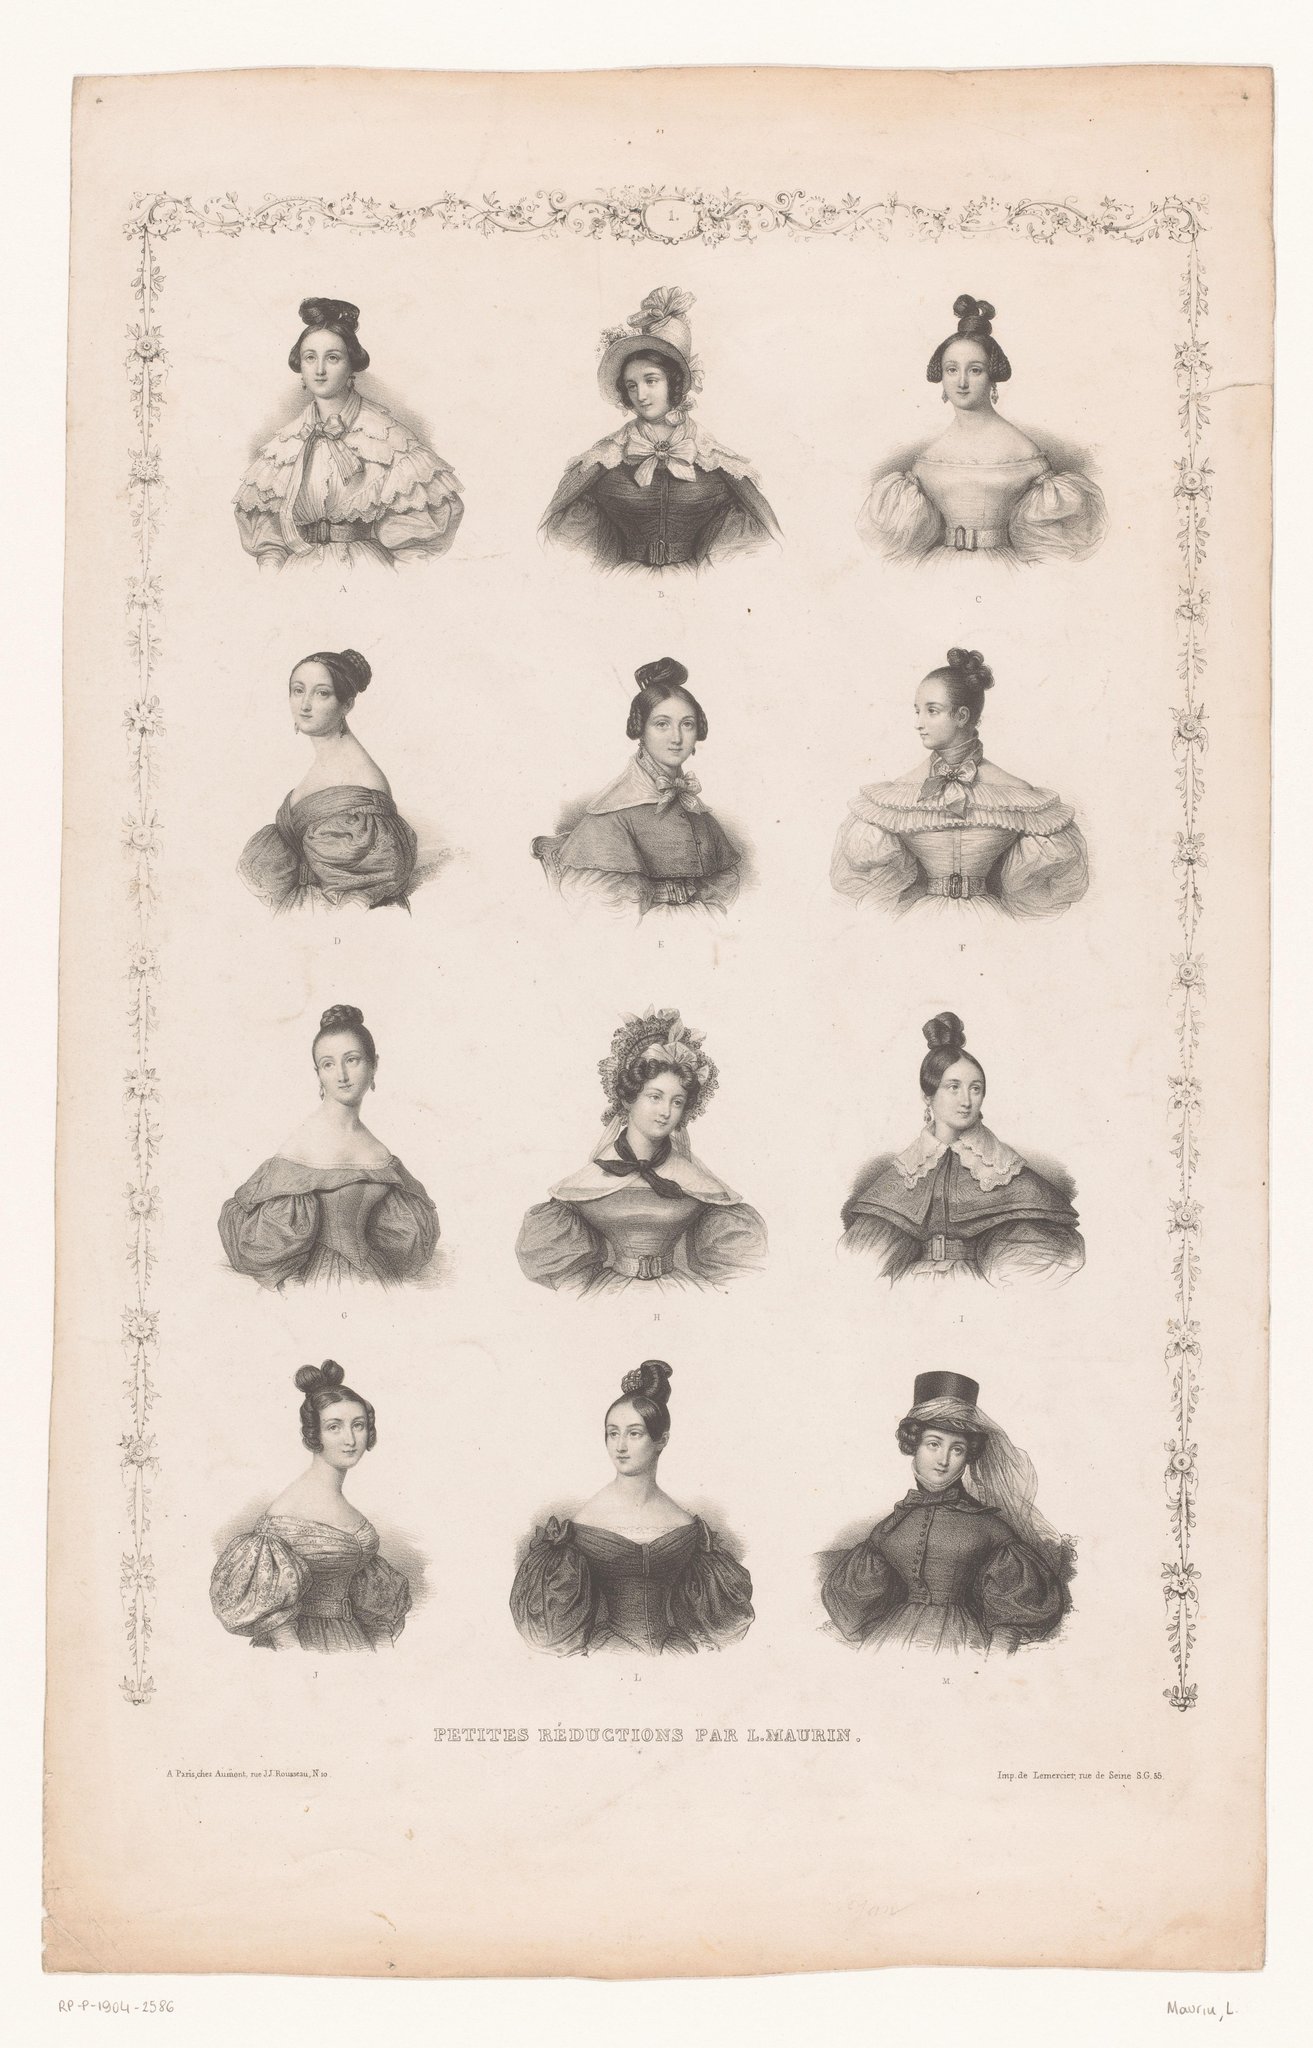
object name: print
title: Petites réductions par L. Maurin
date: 1828-1839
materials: paper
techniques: lithograph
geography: paris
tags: fashion, clothing, female sex; woman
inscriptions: collector's mark: Lugt 2228